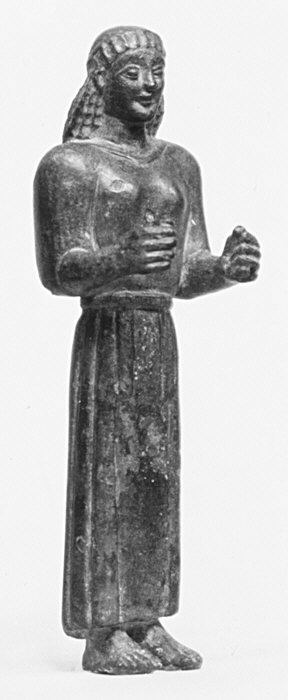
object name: statuette of a horse from chariot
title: Bronze charioteer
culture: greek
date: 500 BCE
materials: bronze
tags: women